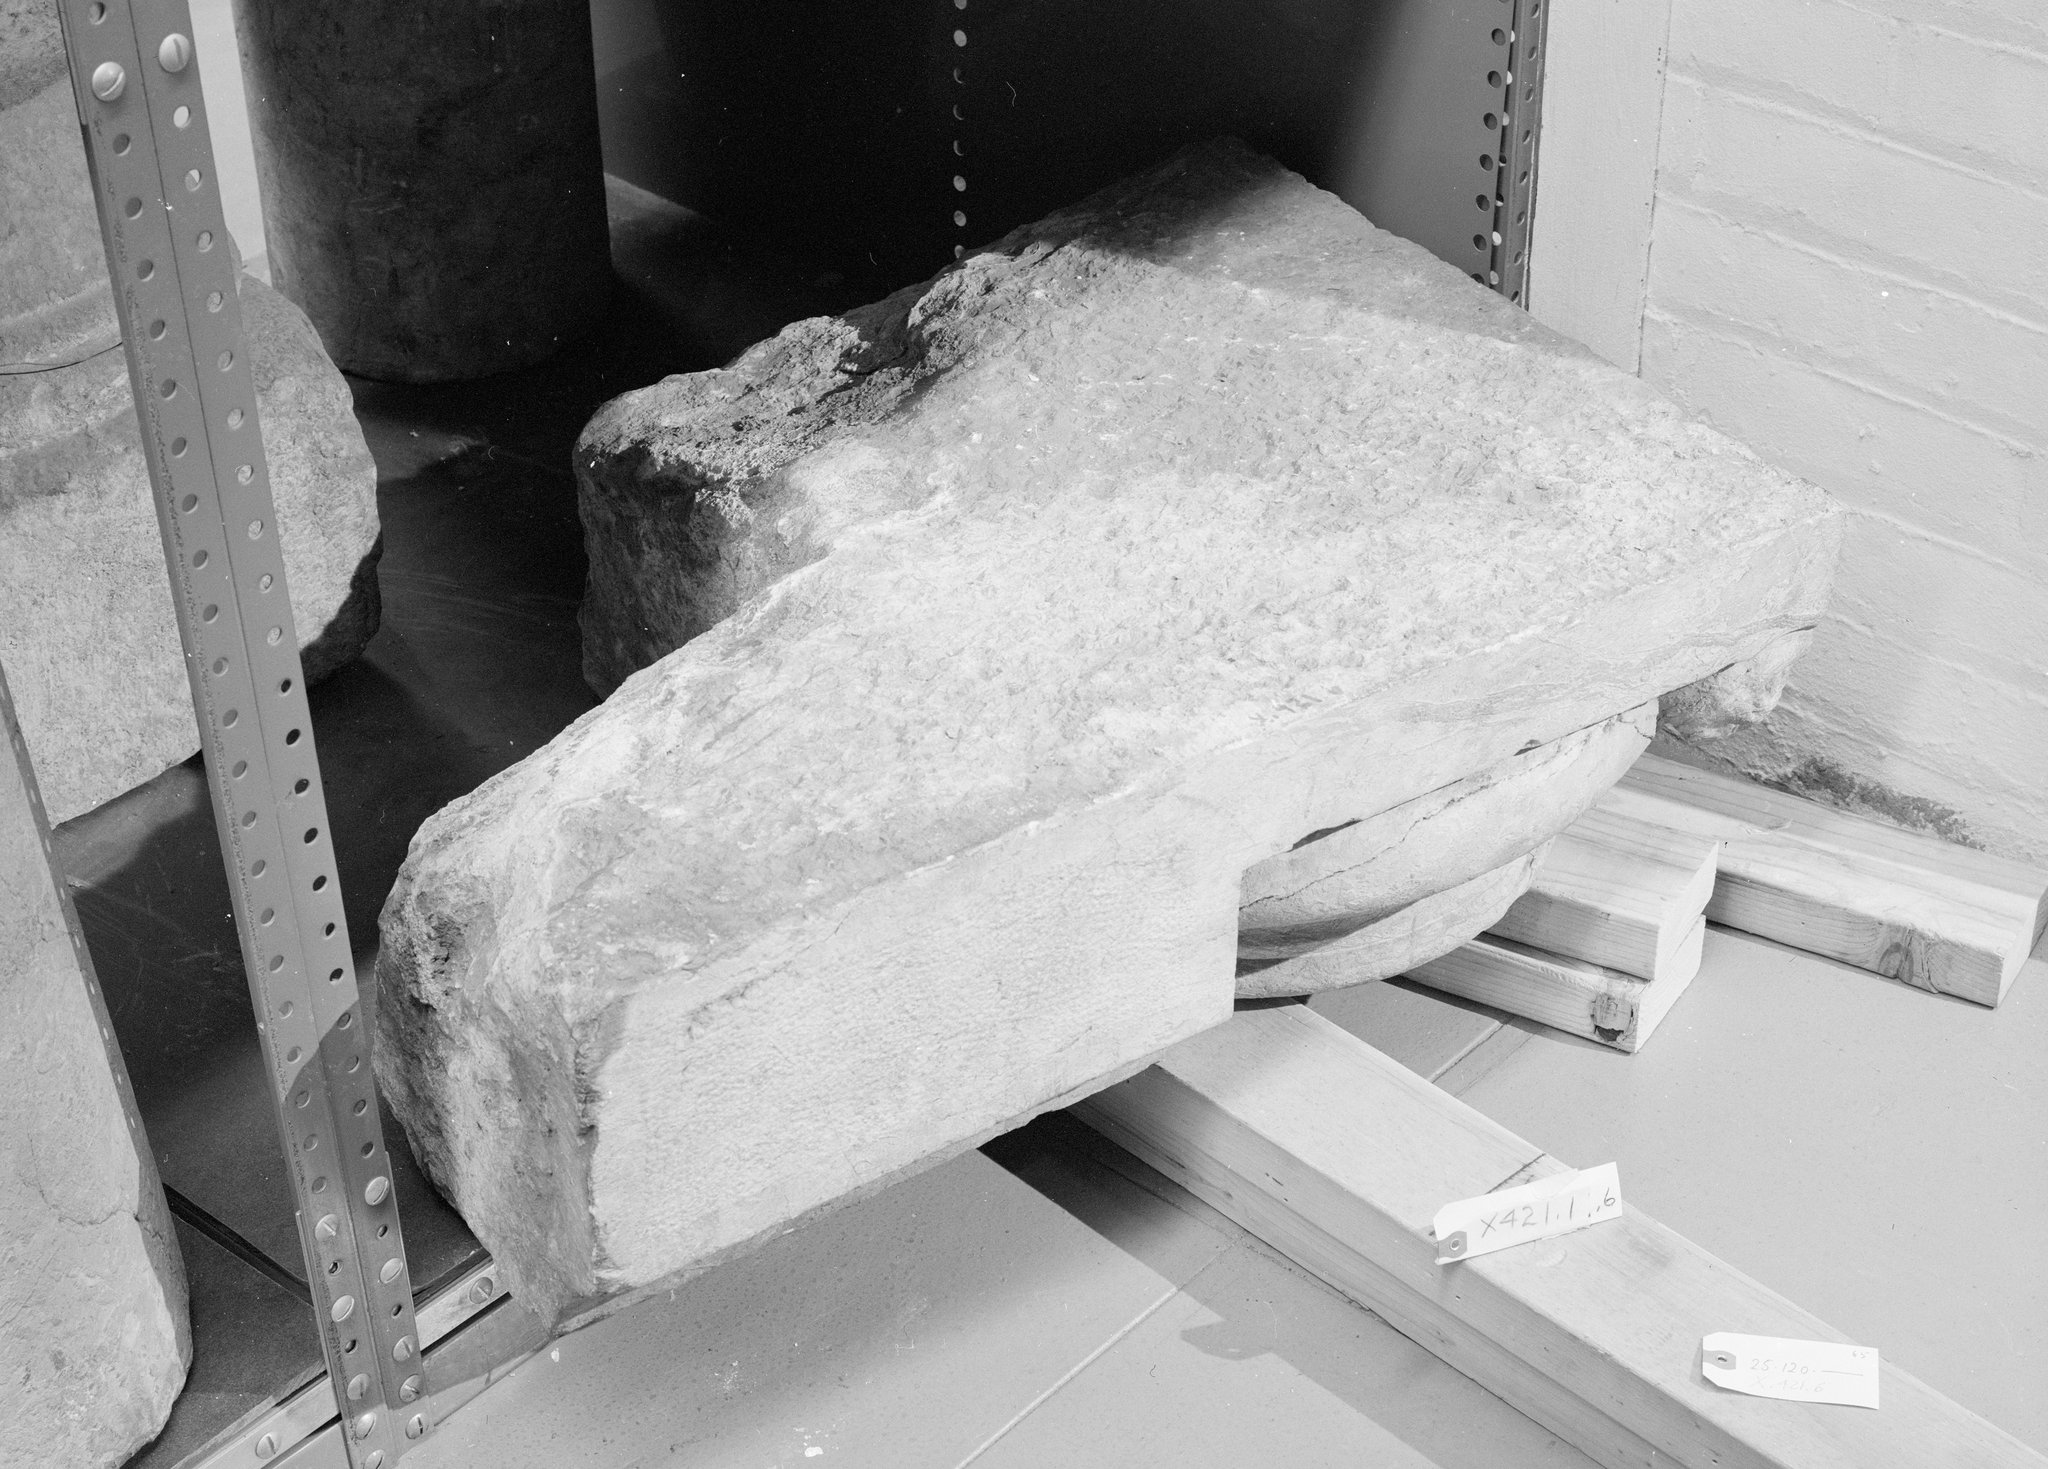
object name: base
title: Engaged Base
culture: french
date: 1130-1140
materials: stone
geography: france